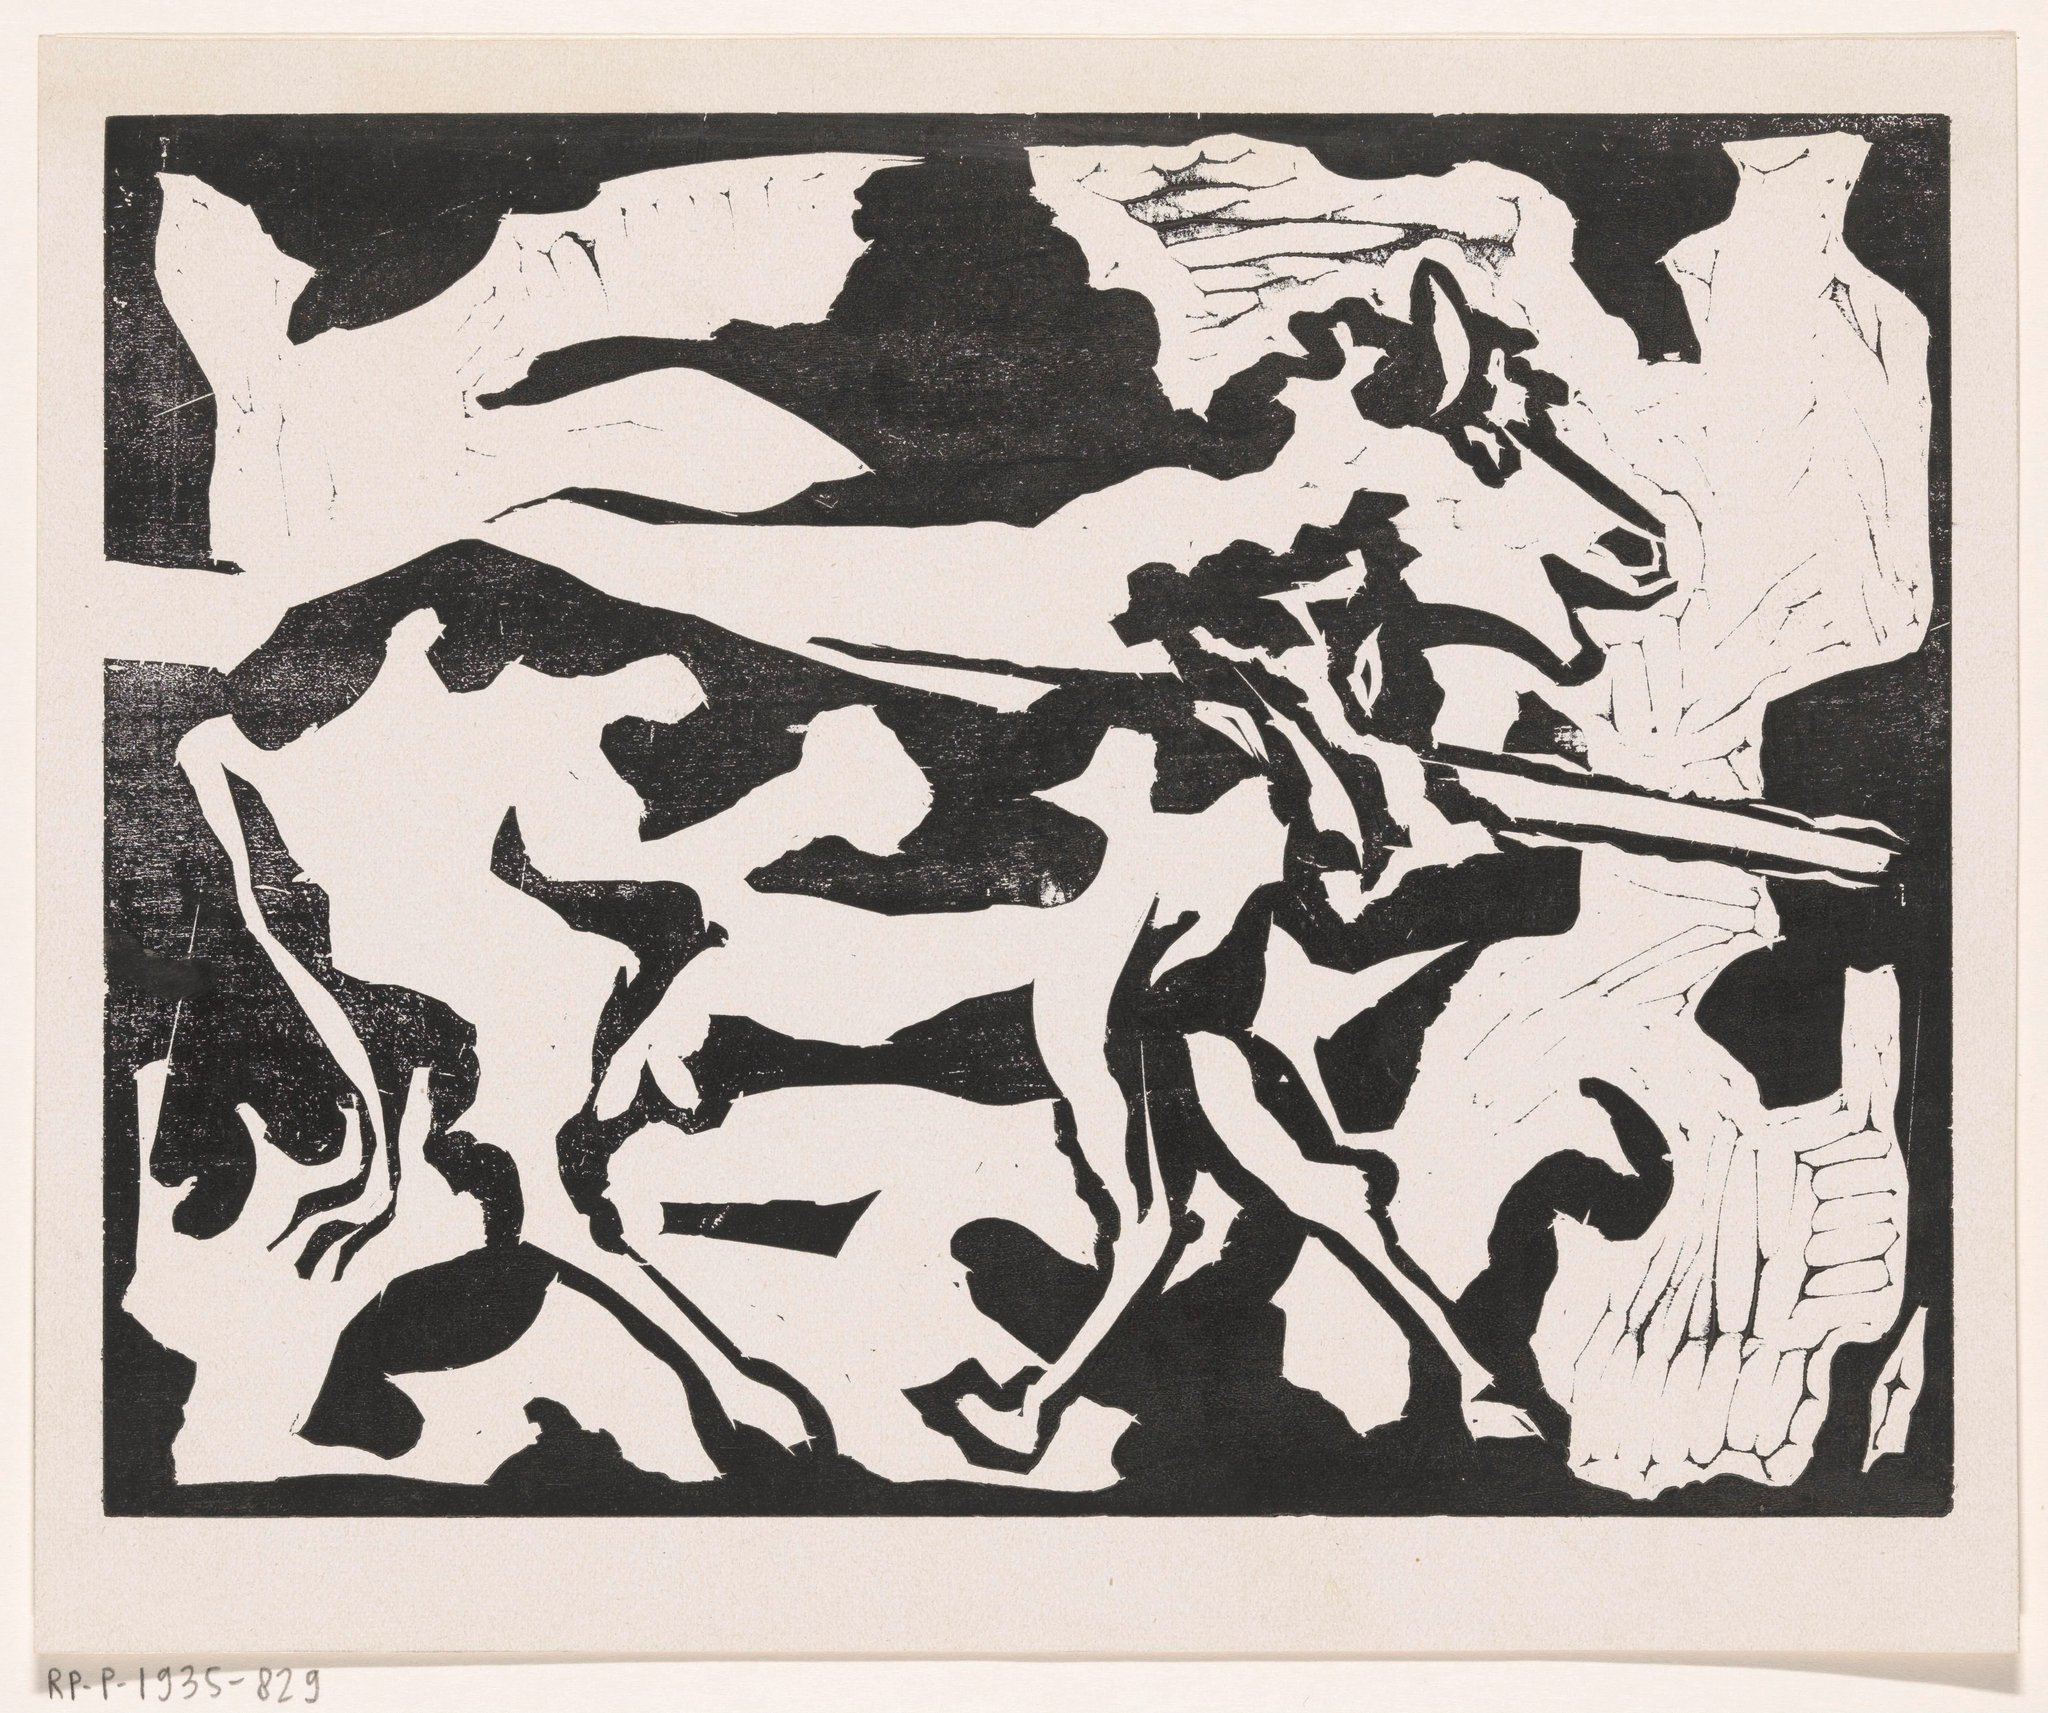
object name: print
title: Twee koeien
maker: adriaan korteweg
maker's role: print maker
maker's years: 1890-1917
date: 1900-1917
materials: paper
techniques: woodcut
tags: bovine cattle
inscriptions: collector's mark: Lugt 2228, collector's mark: Lugt 2760